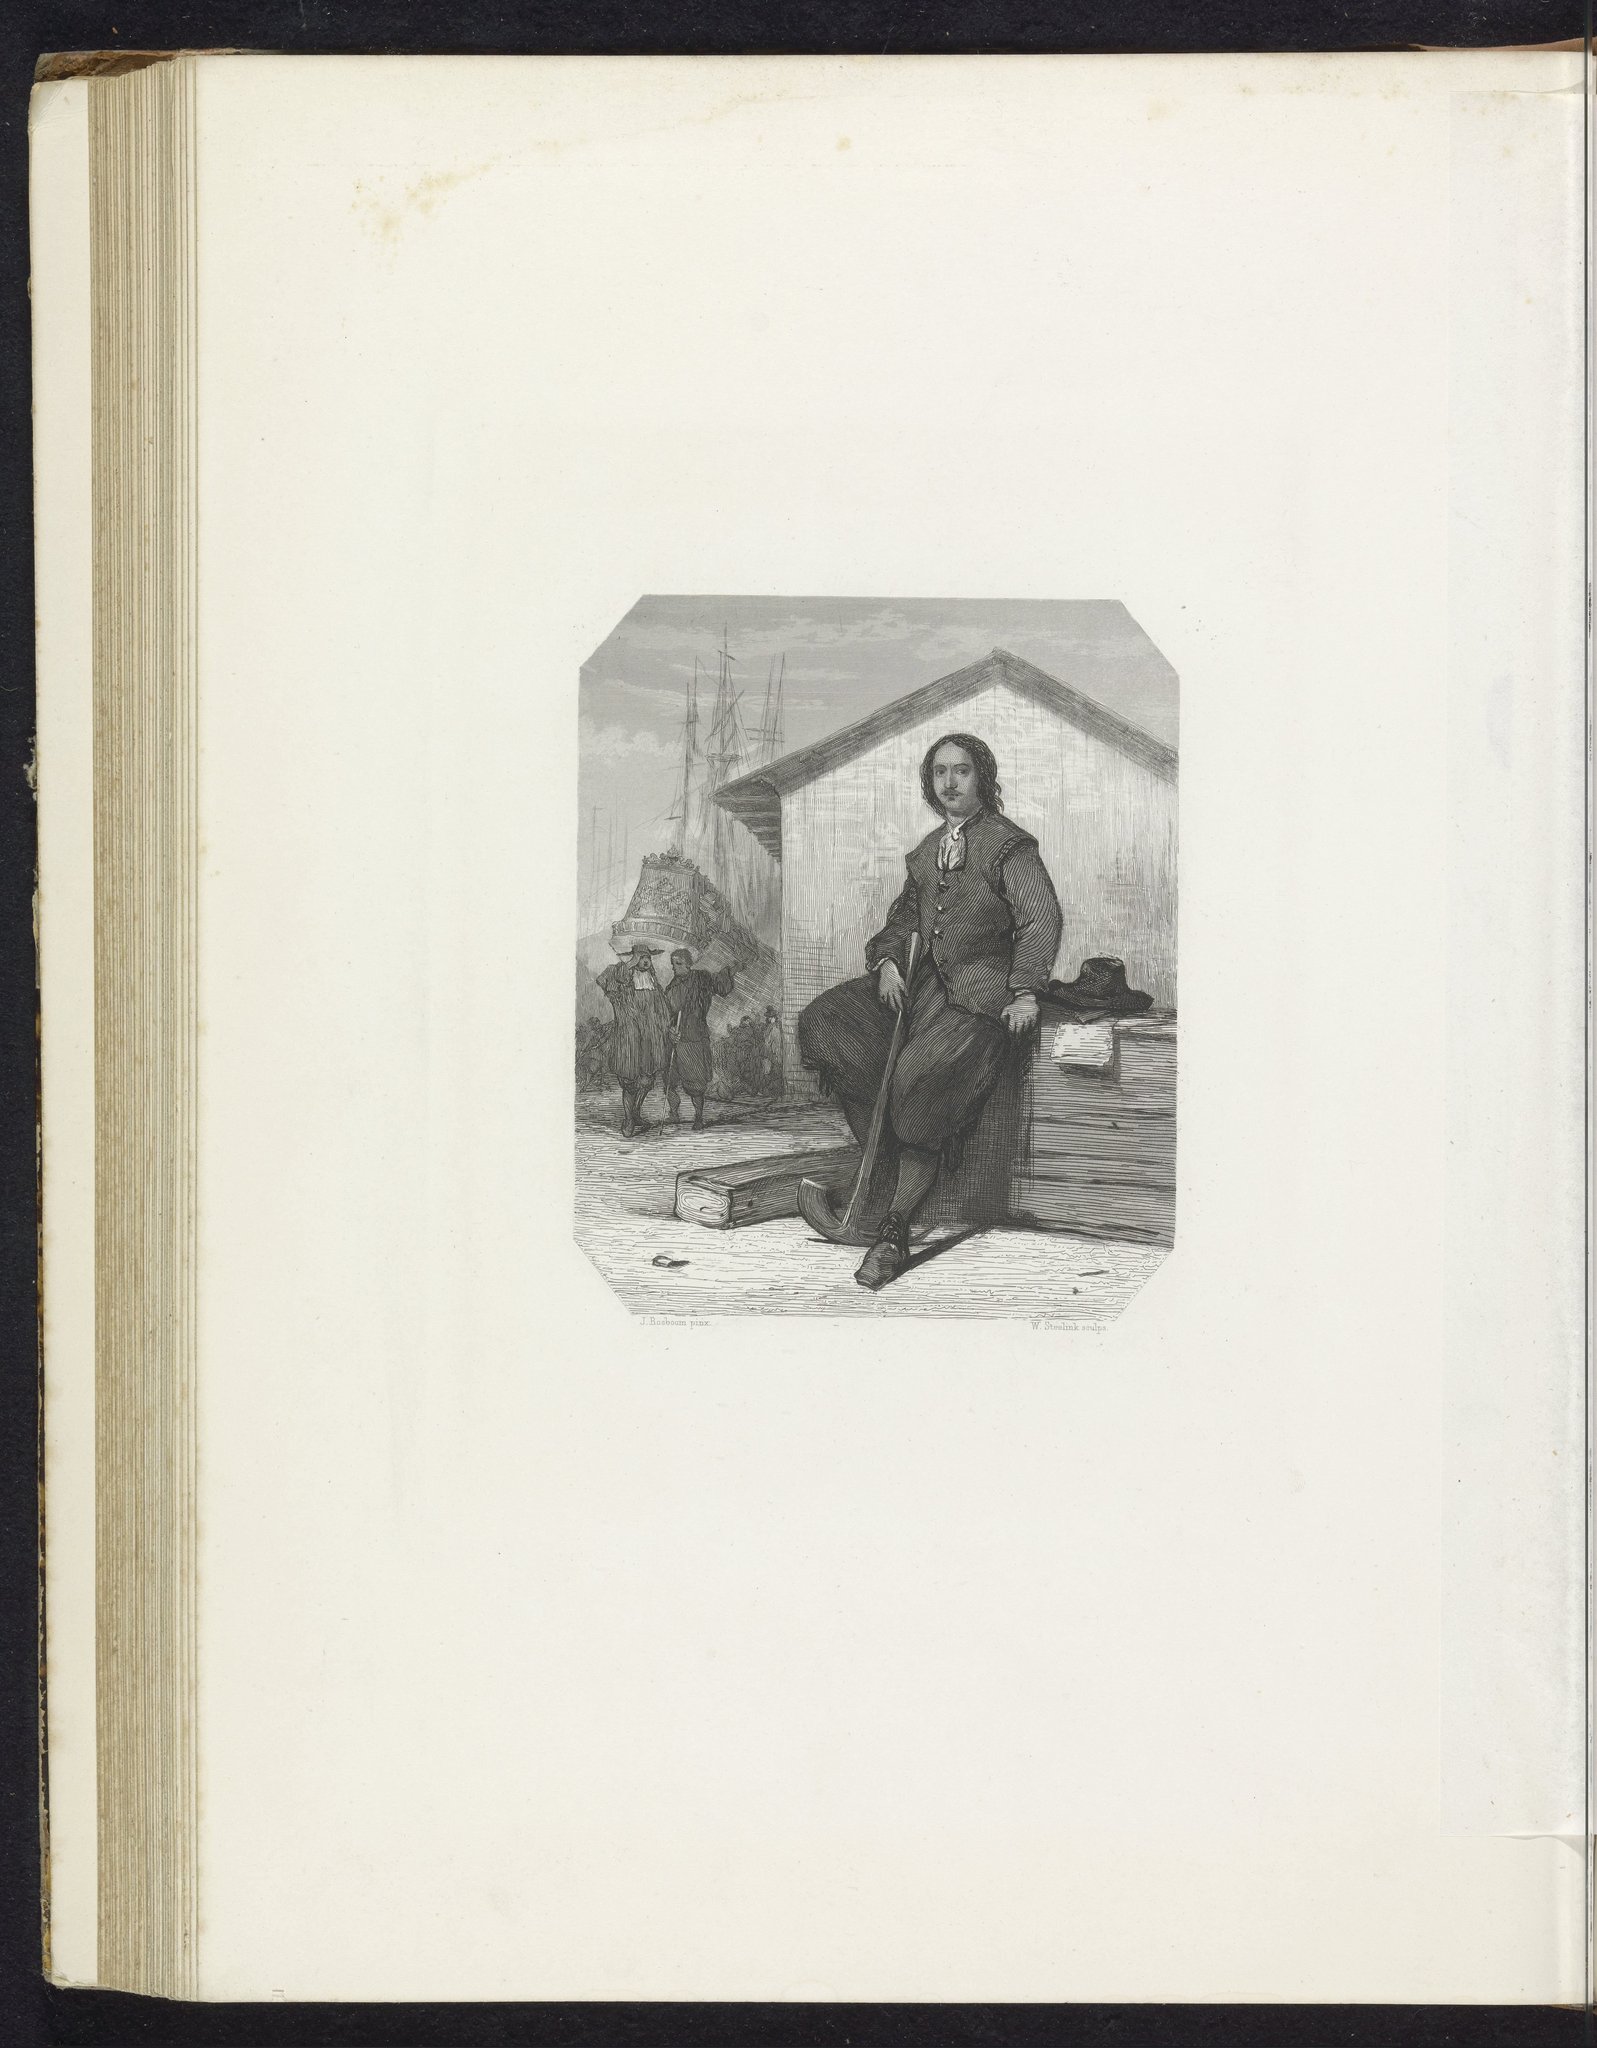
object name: print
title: Tsaar Peter op de Oostindische Werf te Amsterdam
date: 1865-1870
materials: paper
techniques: engraving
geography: netherlands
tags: peter i de grote (tsaar van rusland), shipyard-workers, amsterdam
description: Tsaar Peter de Grote op de werf van de VOC te Amsterdam, augustus 1697. Onderdeel van de groep staalgravures naar de schilderijen van de Historische Galerij der Maatschappij Arti et Amicitiae.